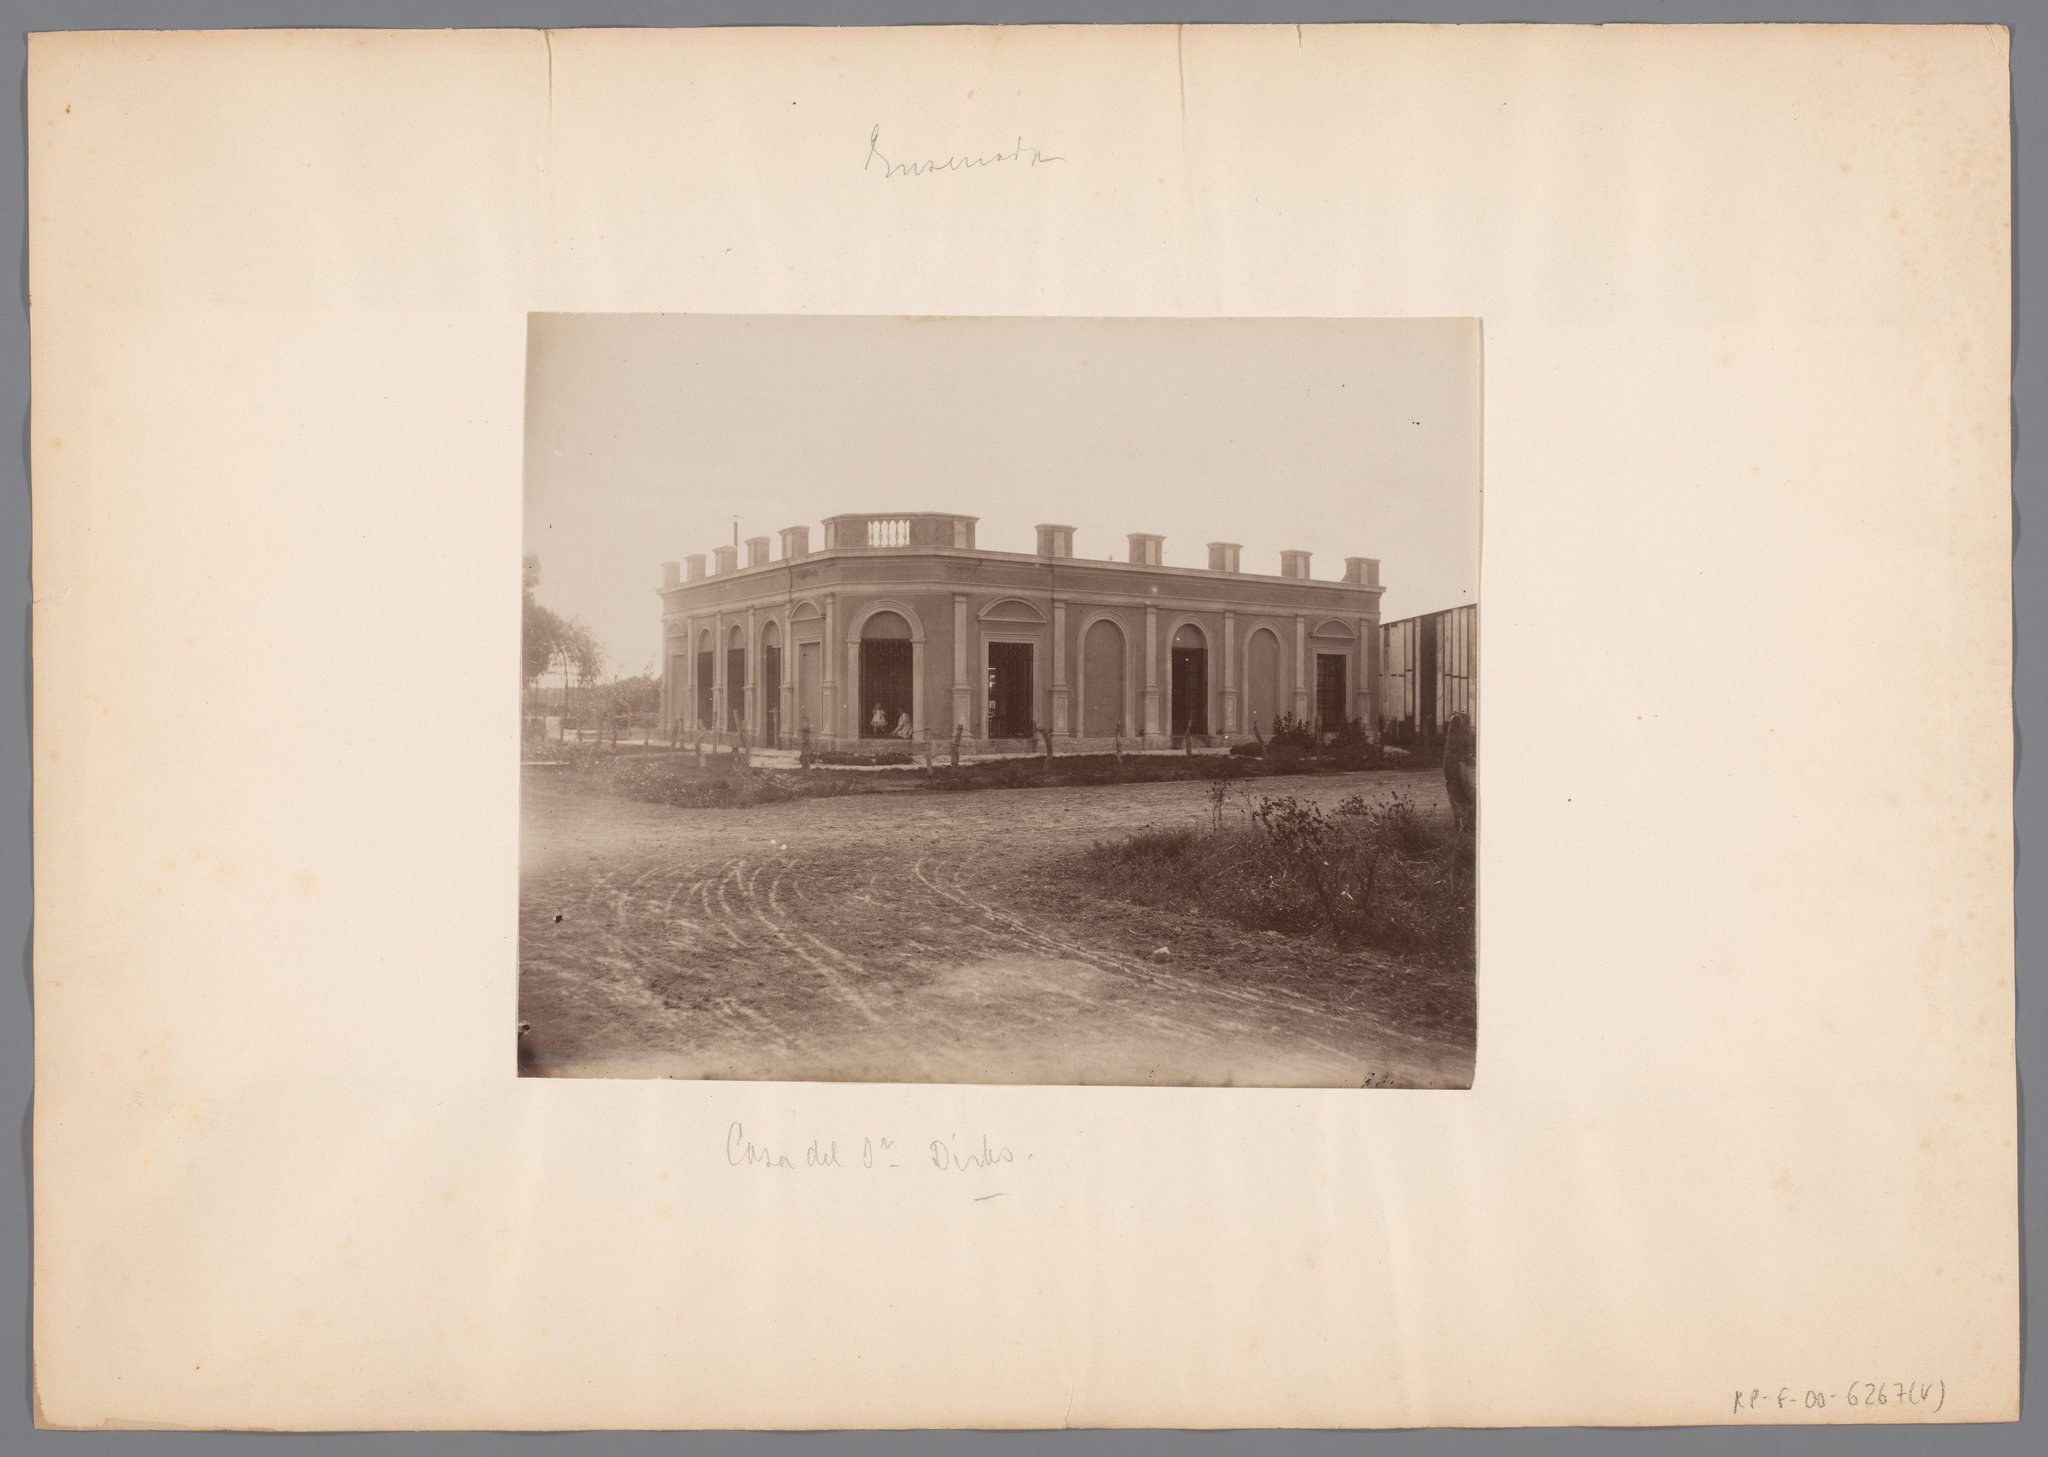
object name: photograph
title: albumblad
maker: Anonymous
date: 1880-1910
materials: paper, photographic support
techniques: albumen print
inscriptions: inscription: ‘Ensenada [?]’, caption: ‘Casa del Dr. Dirks.’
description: Gezicht op een vrijstaand gebouw aan een onverharde weg.